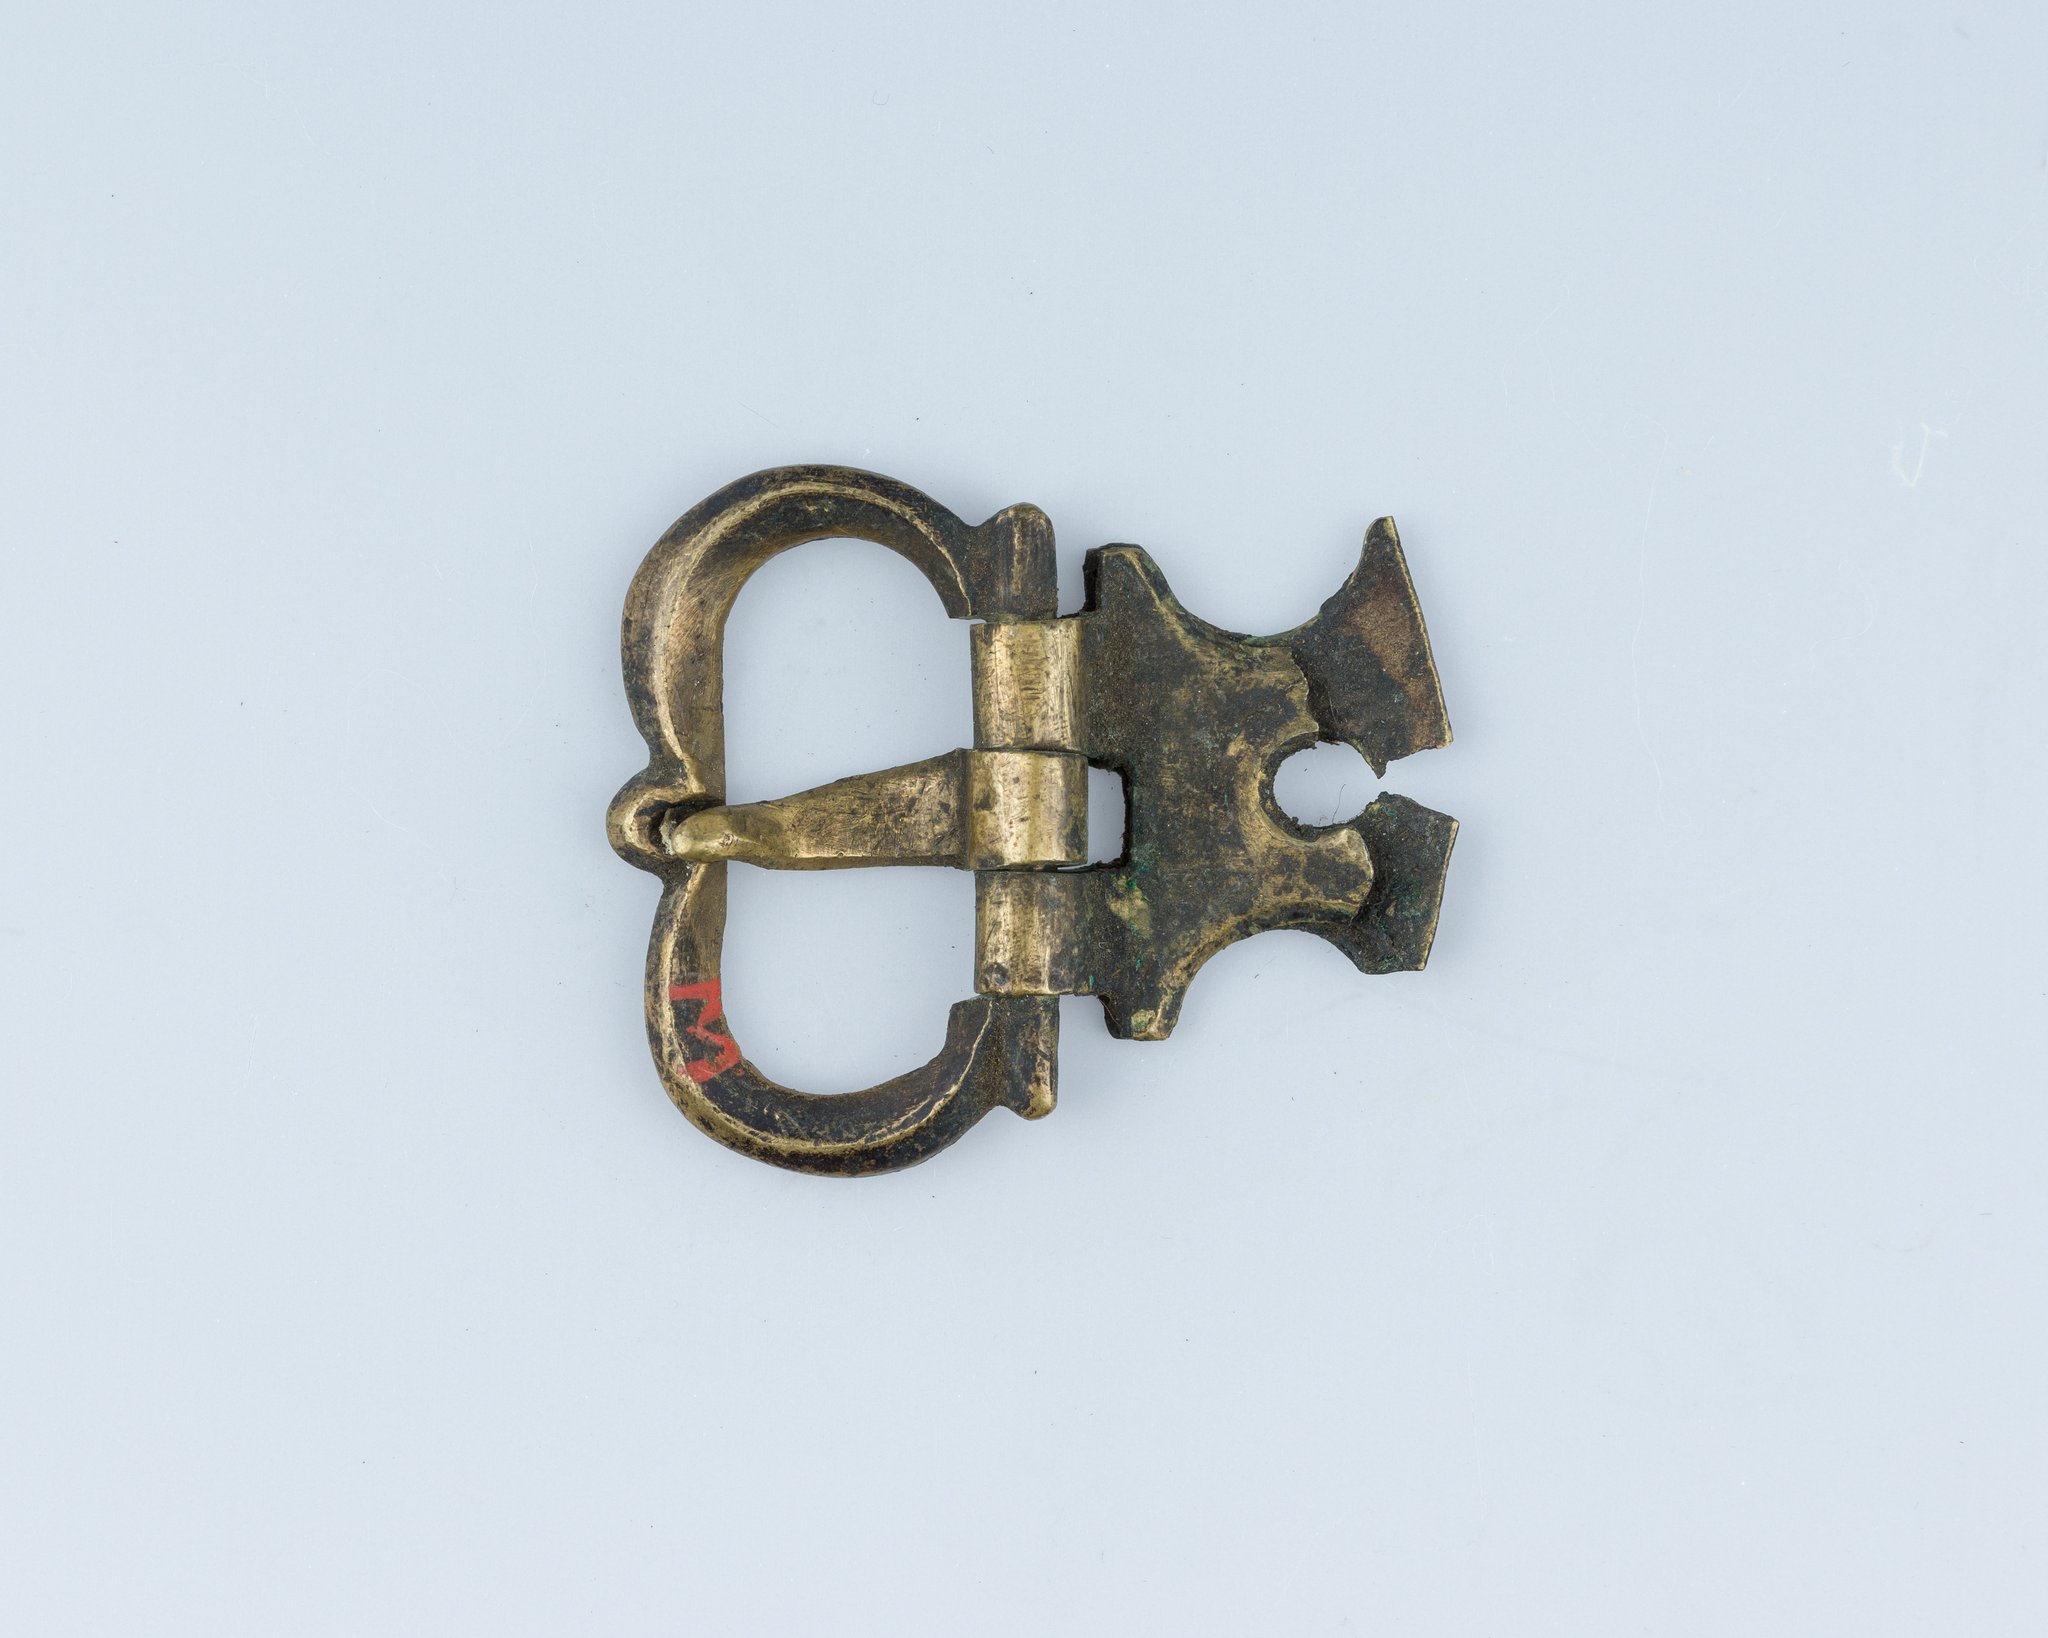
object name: buckle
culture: french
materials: brass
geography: france